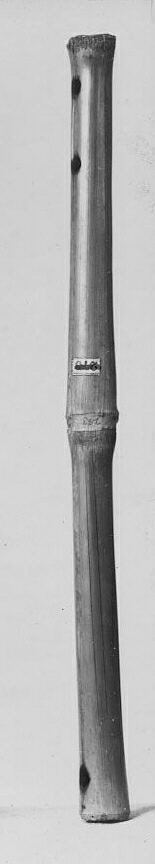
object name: transverse flute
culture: african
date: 1867-1900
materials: bamboo